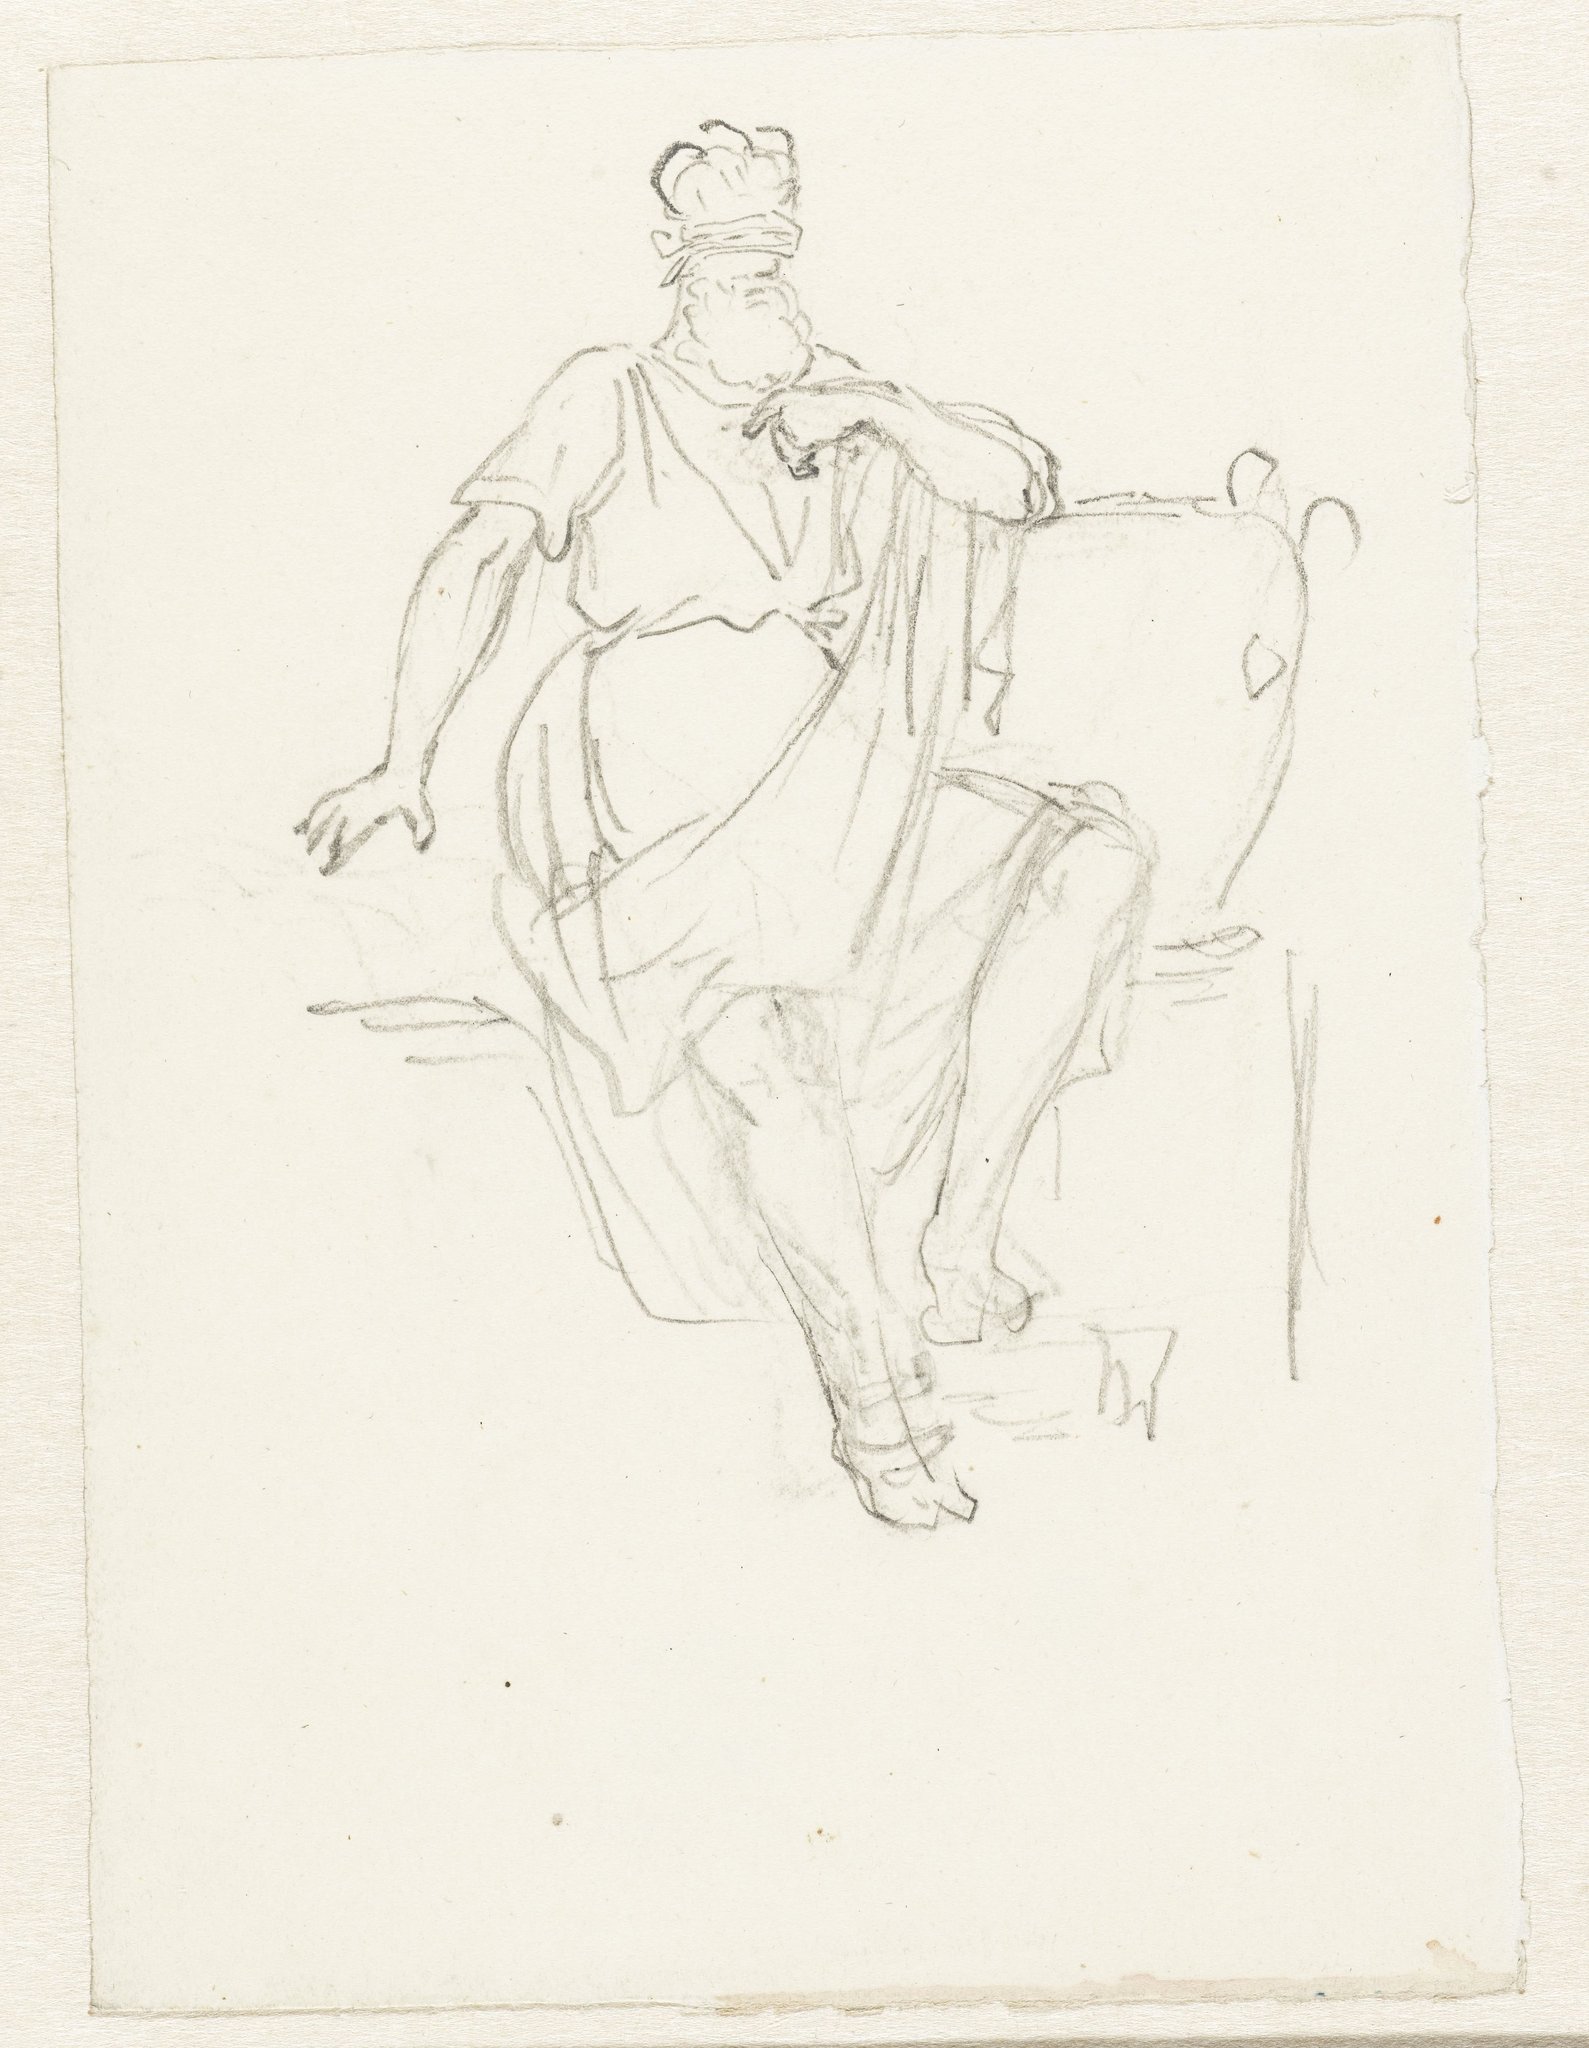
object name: drawing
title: Zittende geblinddoekte man, naast een urn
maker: pieter bartholomeusz. barbiers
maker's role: draughtsman, print maker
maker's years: 1772-1837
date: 1782-1837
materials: graphite, paper